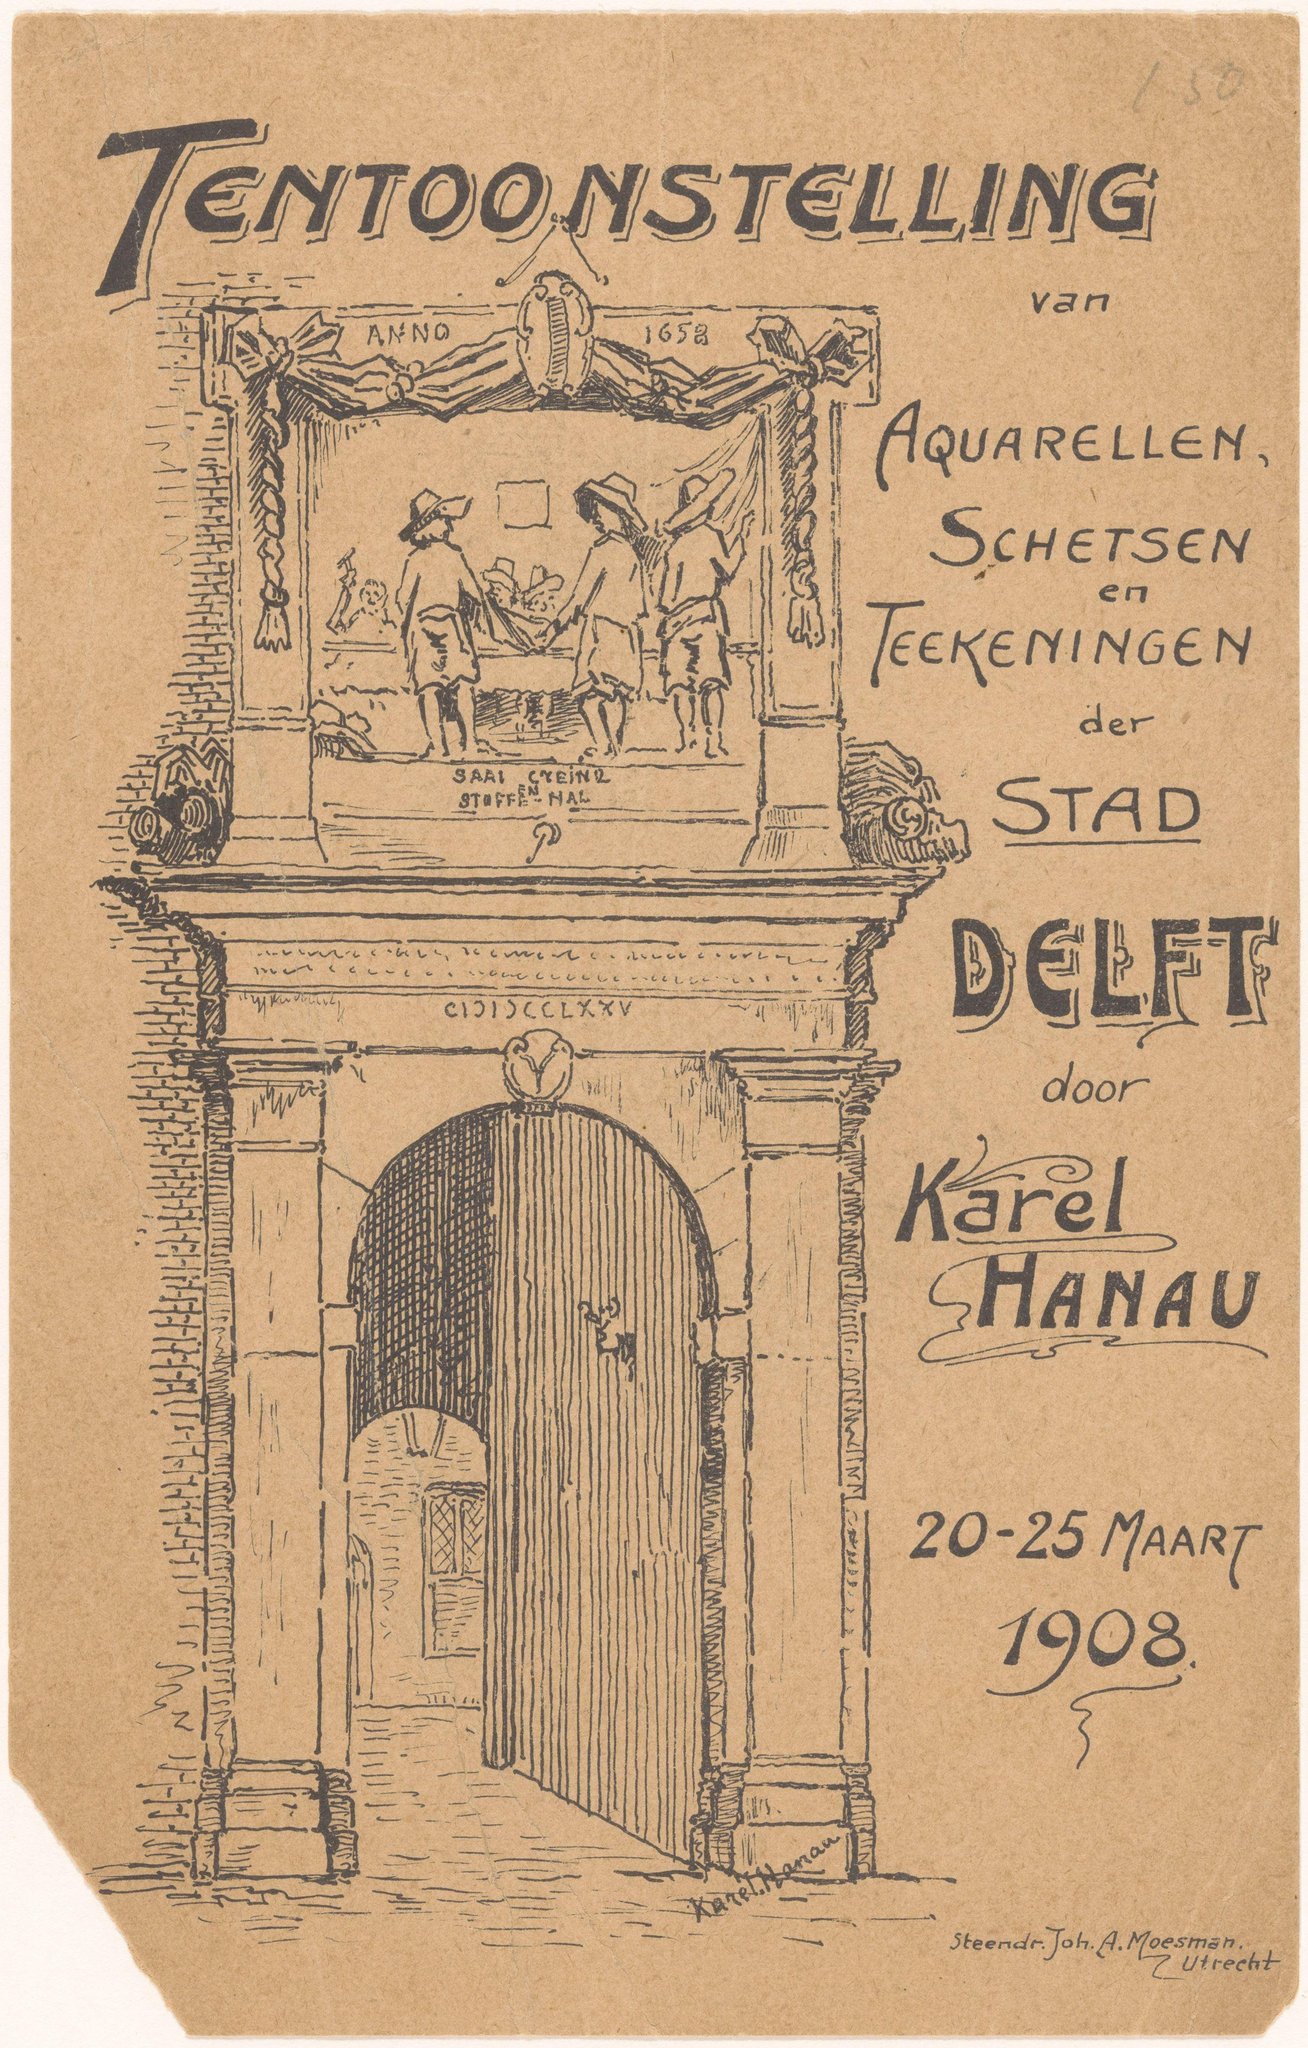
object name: print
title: Aankondiging tentoonstelling Karel Hanau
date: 1908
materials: paper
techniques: lithograph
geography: utrecht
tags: utrecht, painter, draughtsman, karel hanau, temporary exhibition, 'salon', delft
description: 'Aankondiging tentoonstelling van aquarellen, schetsen en tekeningen der stad Delft door karel Hanau 20-25 Maart 1908'. De tekst is geplaatst rond een tekening van de ingangspoort van de Delftse lakenhal.